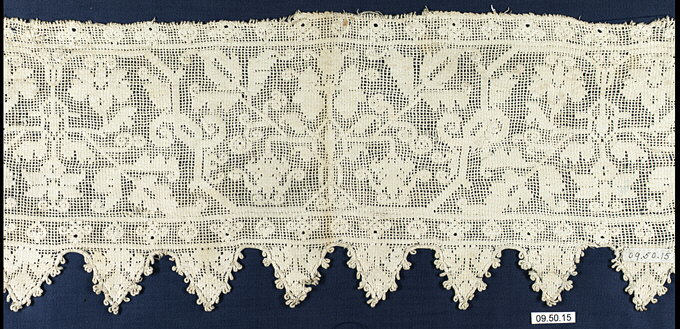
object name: fragment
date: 1601-1700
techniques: embroidery